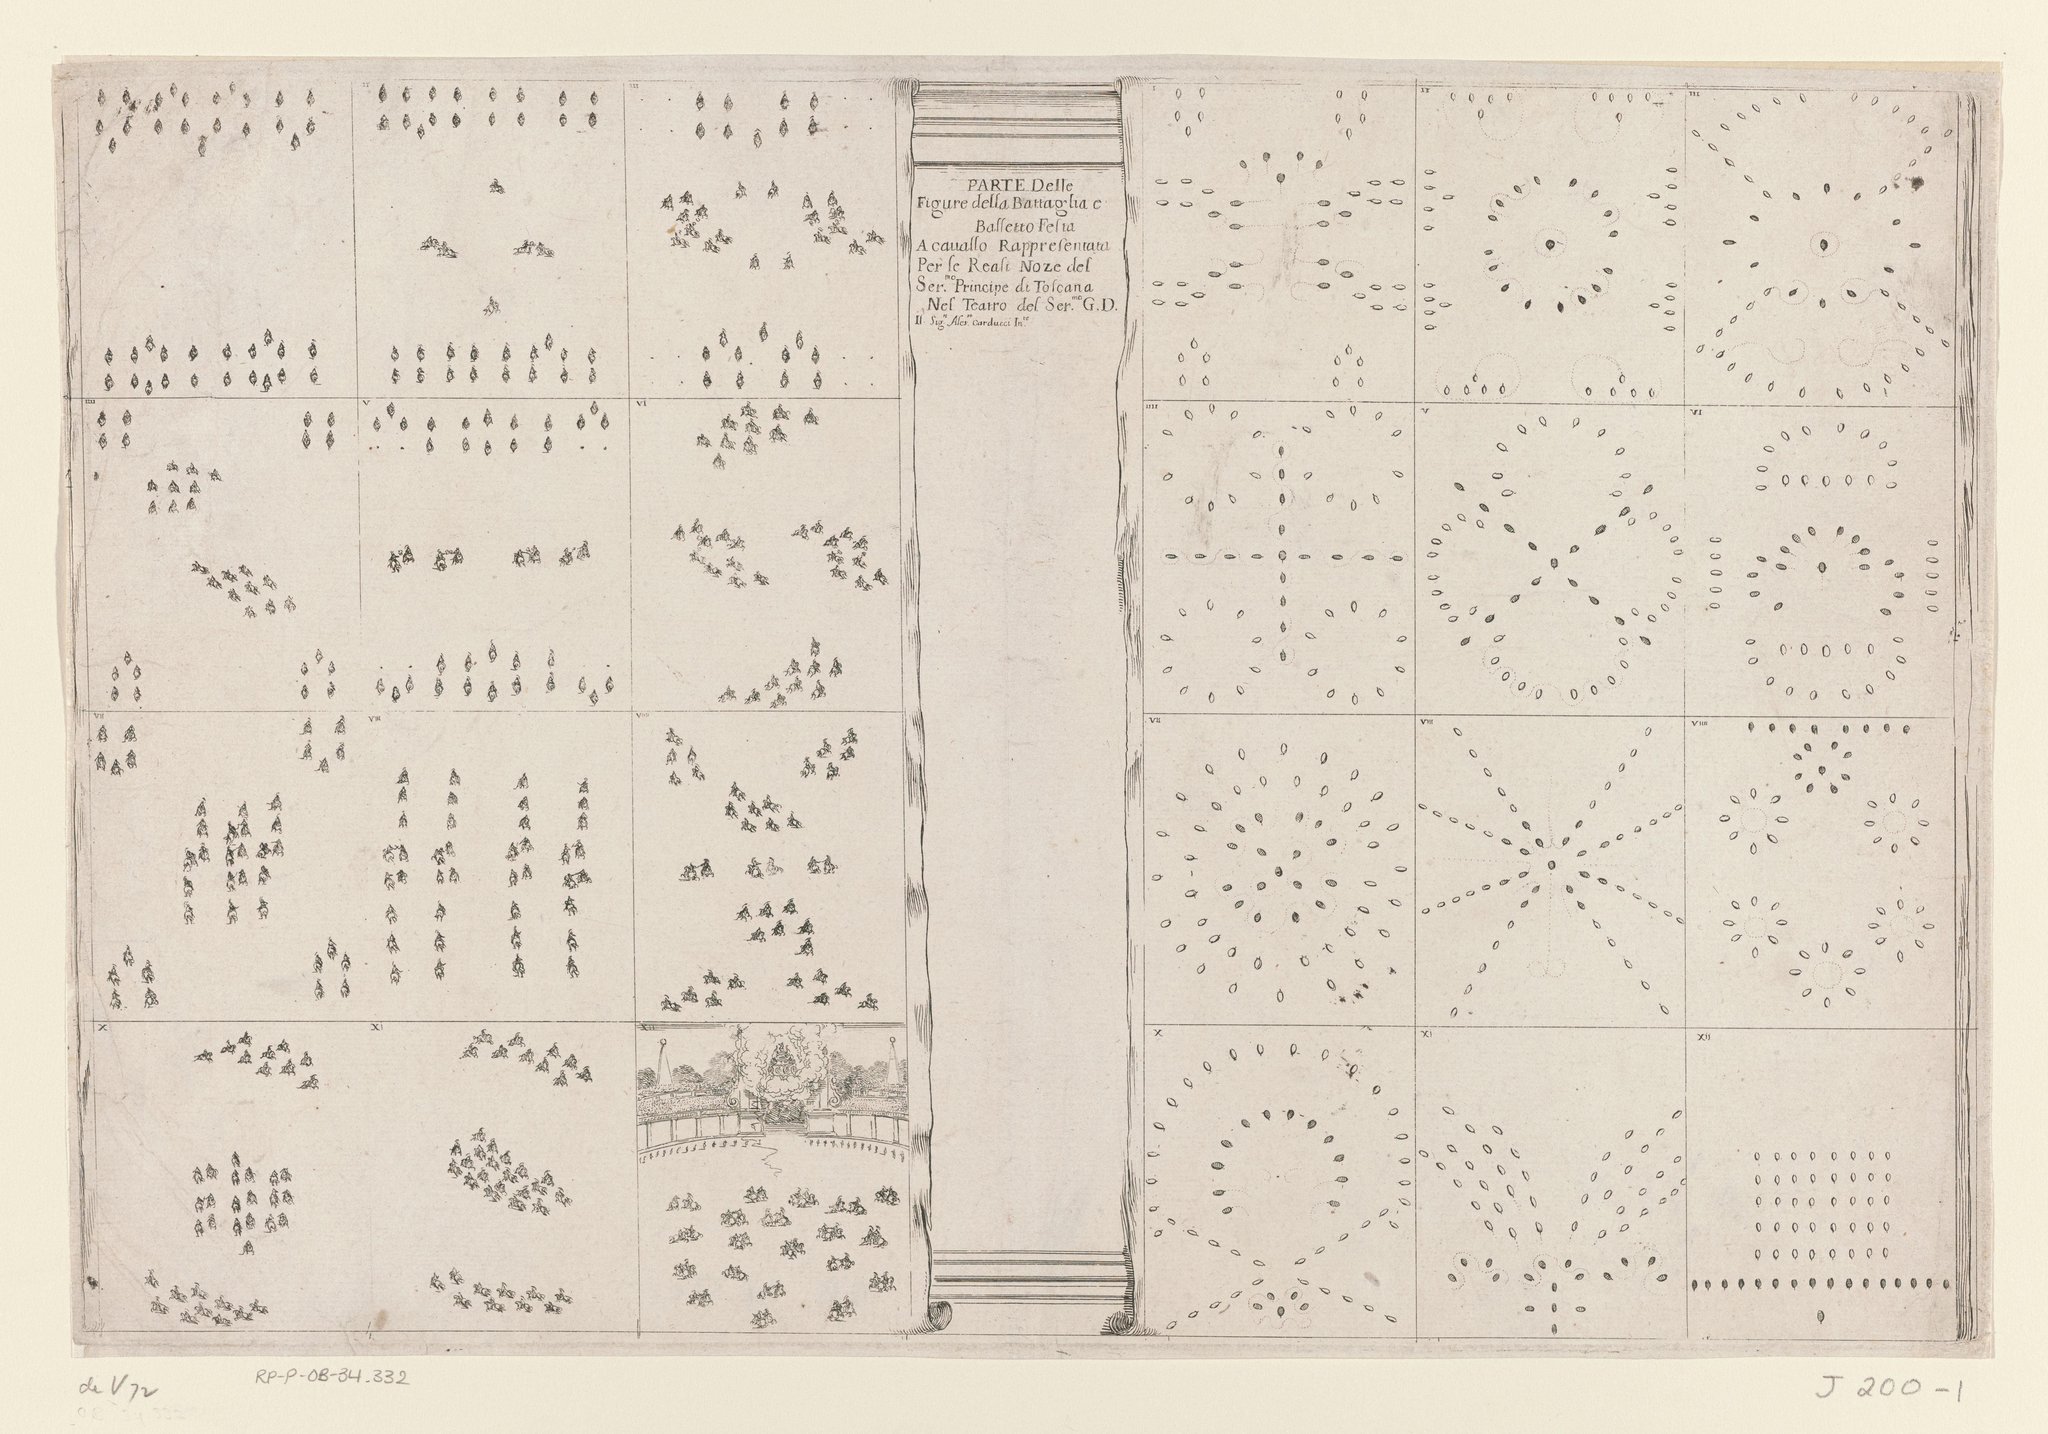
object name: print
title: Paardenballet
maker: stefano della bella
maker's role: draughtsman, print maker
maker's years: 1610-1664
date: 1620-1664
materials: paper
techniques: etching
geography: italy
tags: riding a horse, ass, or mule; rider, horseman, festivities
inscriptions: collector's mark: Lugt 240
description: Getekende voorstudie wordt bewaard in de Biblioteca Marucelliana te Florence (inv. nr. Vol. D, N. 93).